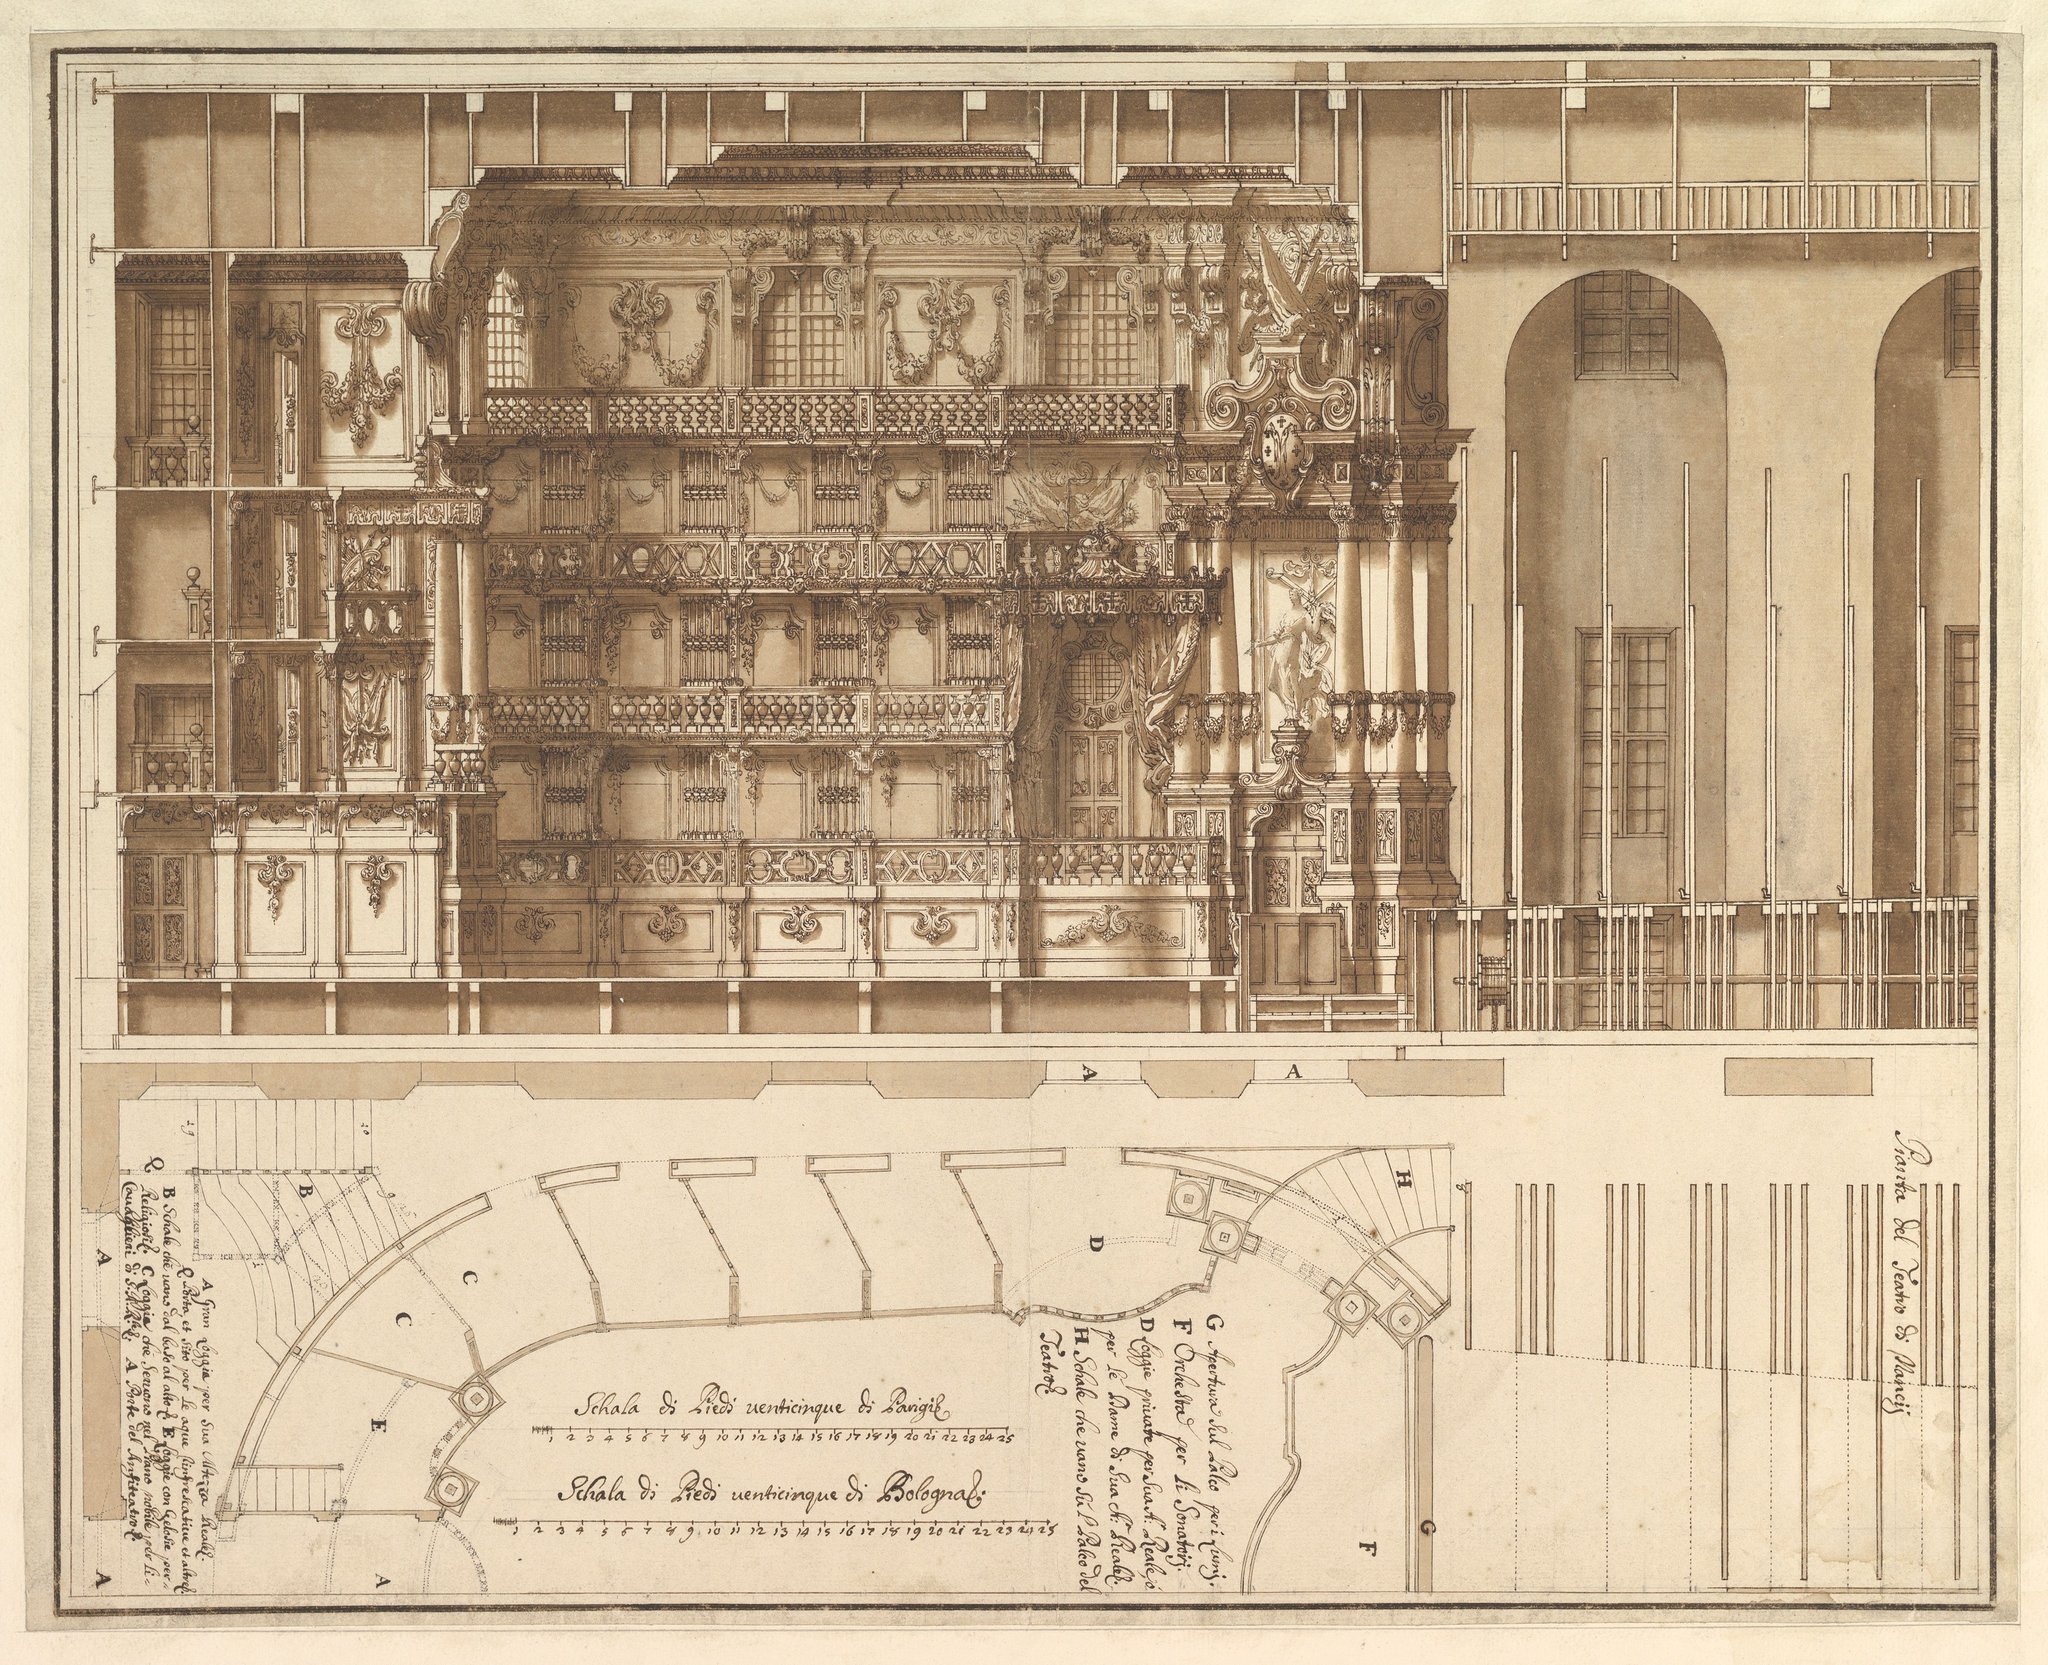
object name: drawing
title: Designs for the Theater at Nancy: Longitudinal Section and Half Ground Plan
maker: francesco galli bibiena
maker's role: artist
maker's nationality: italian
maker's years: 1659-1739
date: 1709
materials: ink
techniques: brush, pen, wash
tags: theatre,architecture